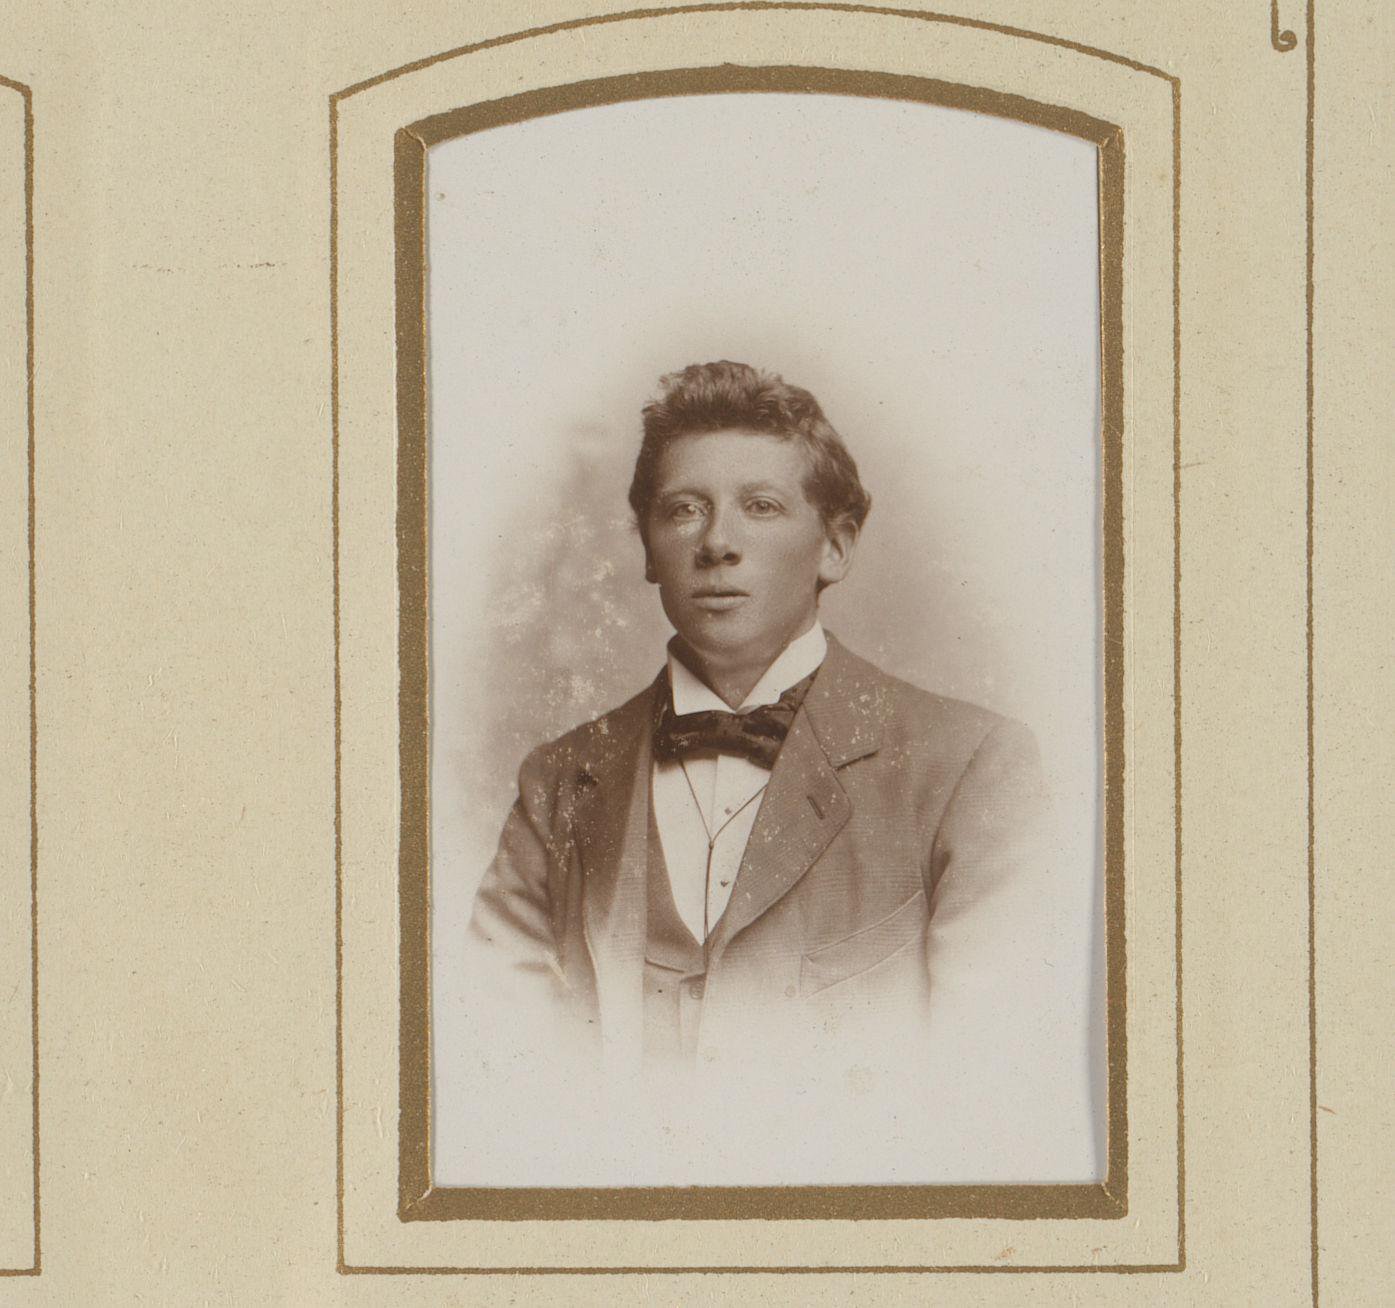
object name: carte de visite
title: Portret van een jonge man met vlinderstrik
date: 1885-1906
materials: cardboard, photographic support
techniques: collodion silver print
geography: amsterdam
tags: historical persons, youth, adolescent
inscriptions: inscription: ‘opgericht 1864./ Amsterdam/ Wester markt, 19/ W.G. Kuijer & Zonen/ Hofphotographen/ Spéciale Inrichting/ voor/ VERGROOTINGEN/ in alle Formaten’